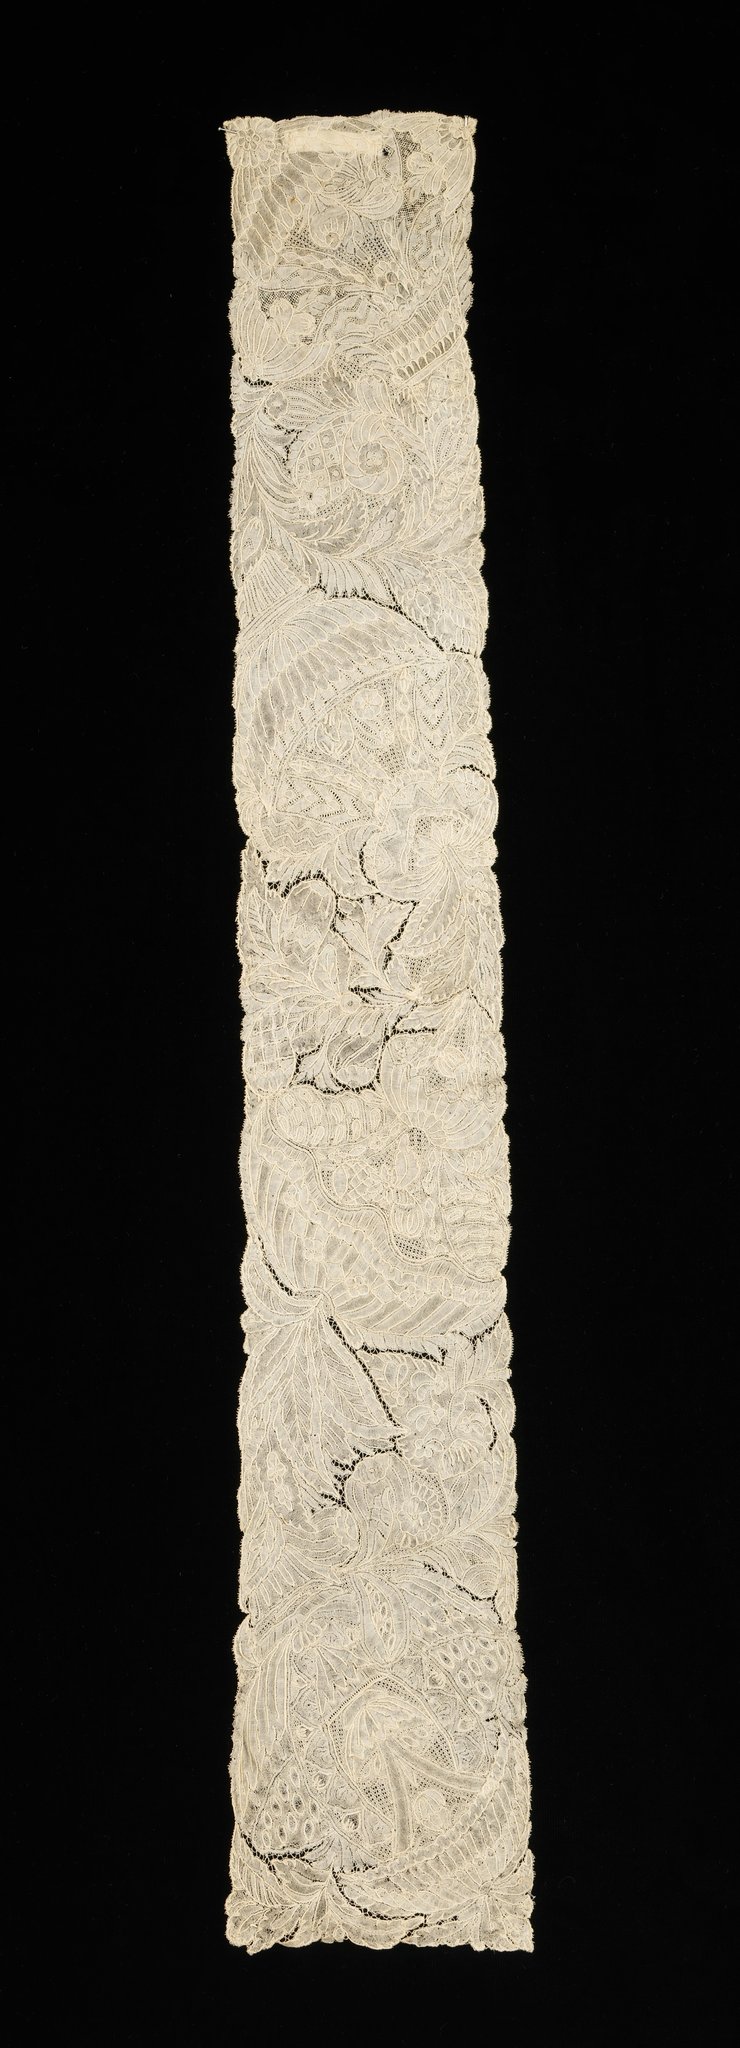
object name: lappet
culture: flemish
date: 1710-1720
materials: linen